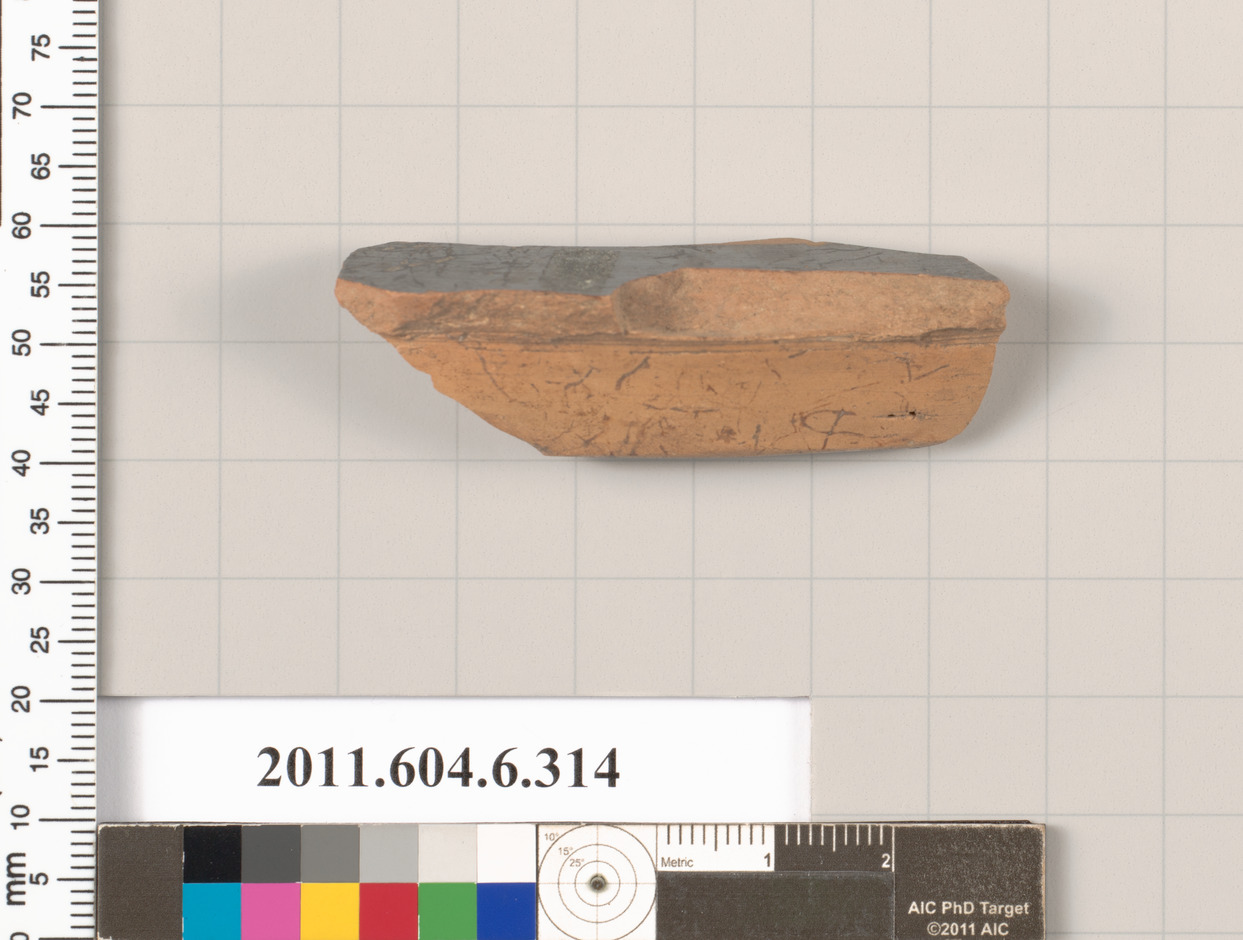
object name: lamp fragment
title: Terracotta fragment of a lamp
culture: greek, attic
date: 600-401 BCE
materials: terracotta